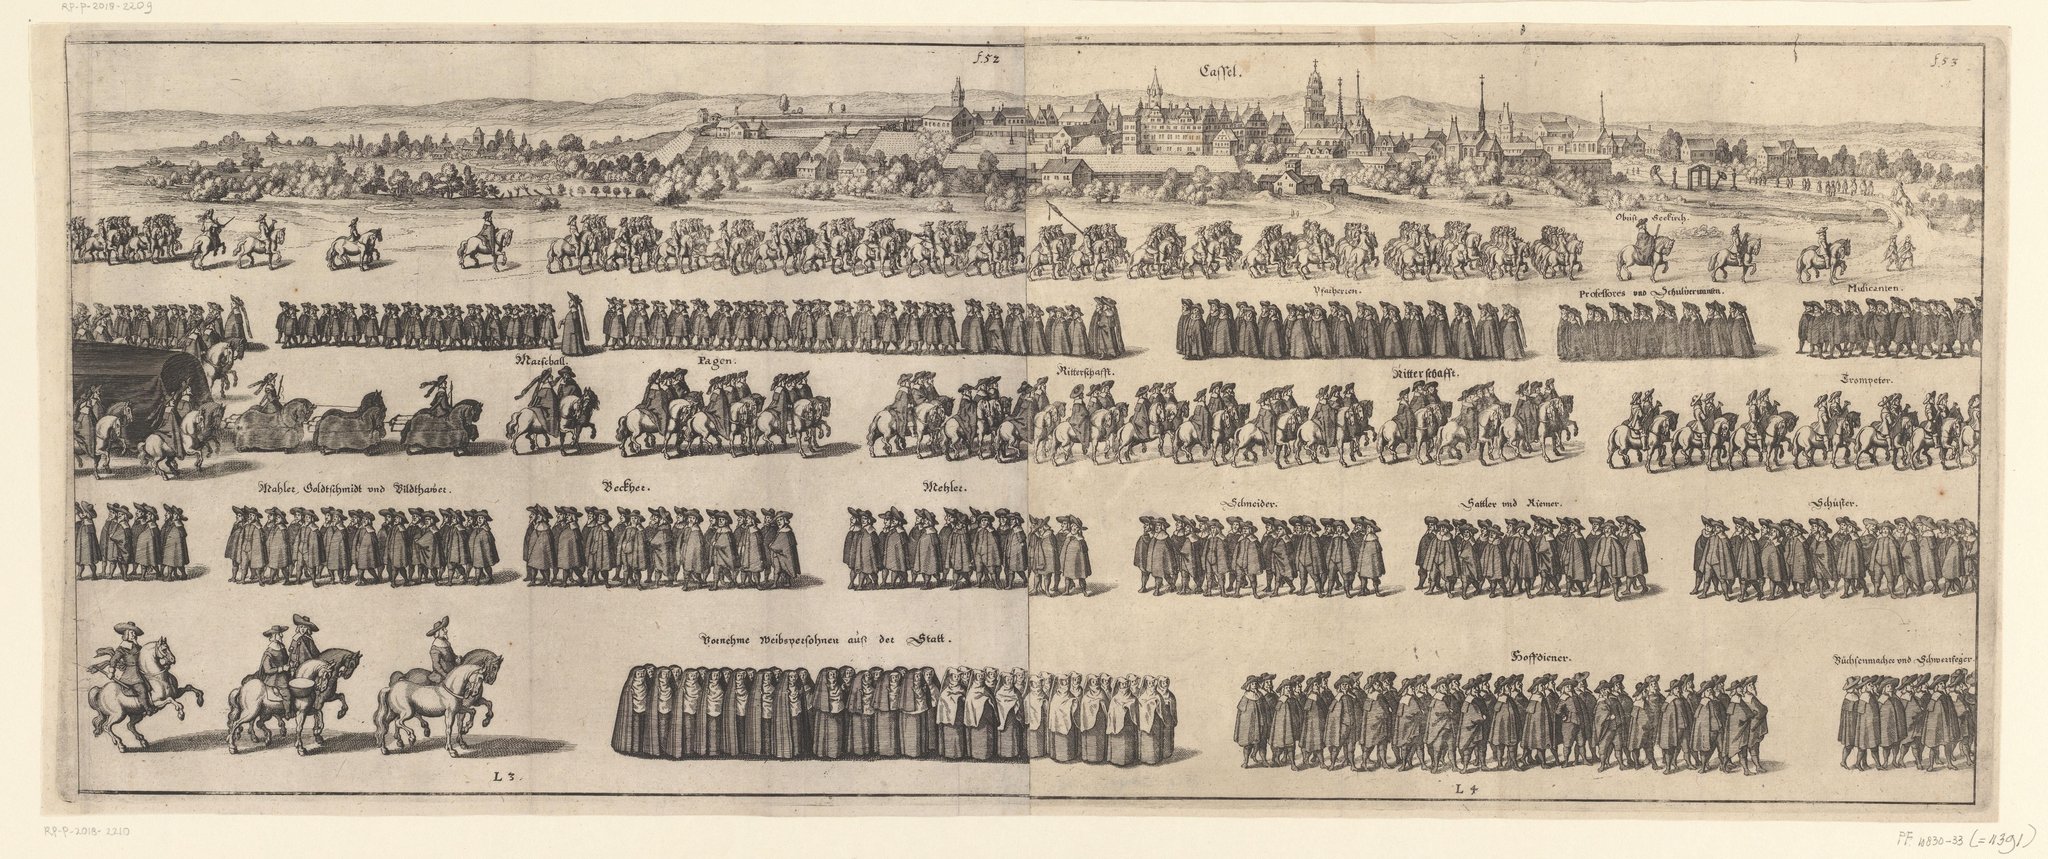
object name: print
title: Begrafenisstoet van Maurits van Hessen-Kassel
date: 1632-1650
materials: paper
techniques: etching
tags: cortege, funeral procession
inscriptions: collector's mark: Lugt 2228